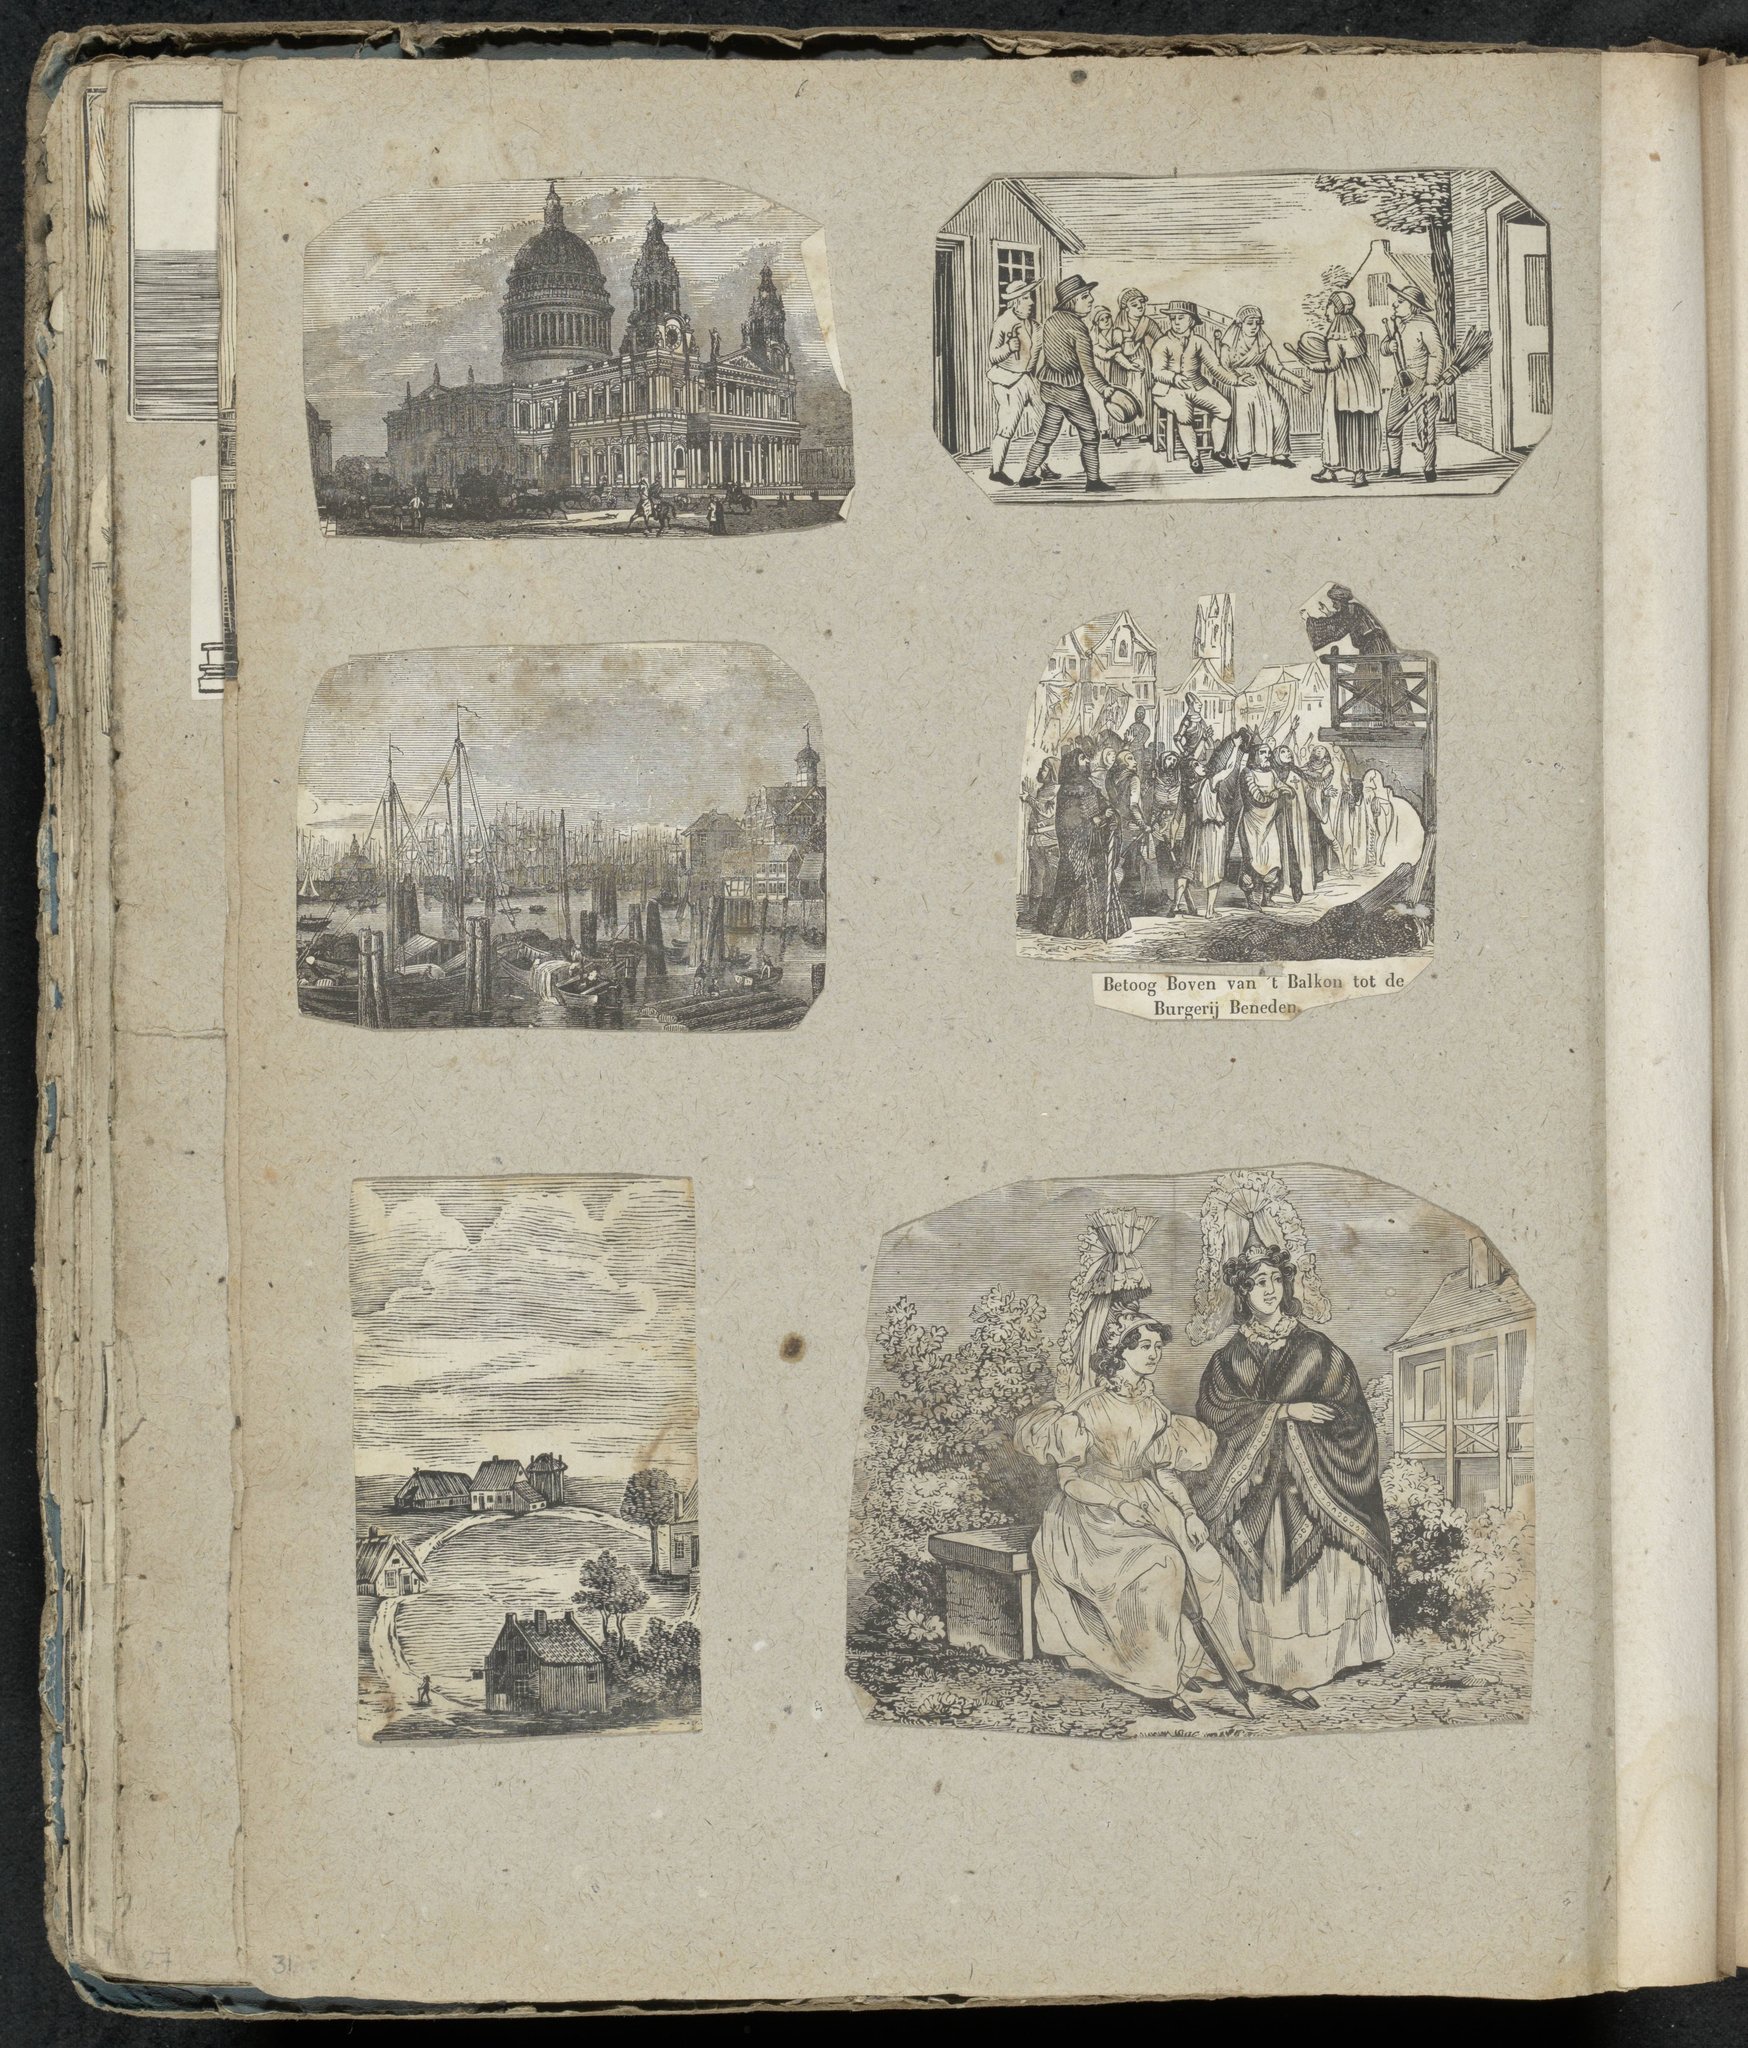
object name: popular print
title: Albumblad met diverse voorstellingen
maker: alexander cranendoncq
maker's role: draughtsman, print maker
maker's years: 1799-1869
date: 1814-1869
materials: paper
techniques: letterpress printing, snipping, engraving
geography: nijmegen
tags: harbour, city-view, and landscape with man-made constructions, head-gear, wedding feast, wedding meal, church (exterior)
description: Albumblad met 6 uitgeknipte voorstellingen uit voornamelijk volksprenten, onder andere van Saint Paul's Cathedral, de bruiloft van Kloris en Roosje, een havengezicht en twee vrouwen met opvallende hoofddeksels. Onder één afbeelding een onderschrift in boekdruk.